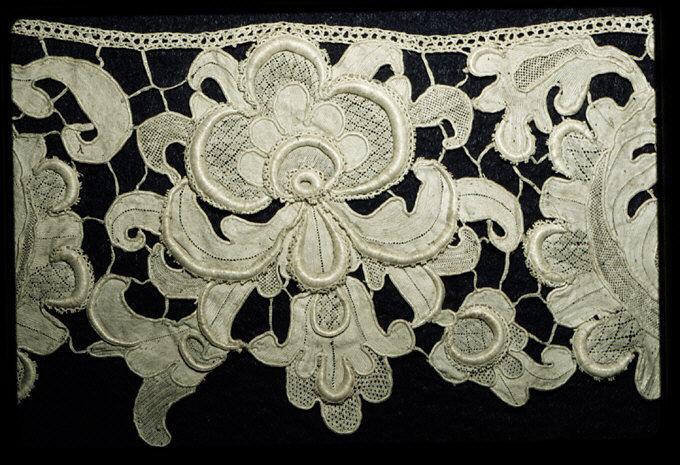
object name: fragment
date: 1601-1700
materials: lace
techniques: gros point, lace